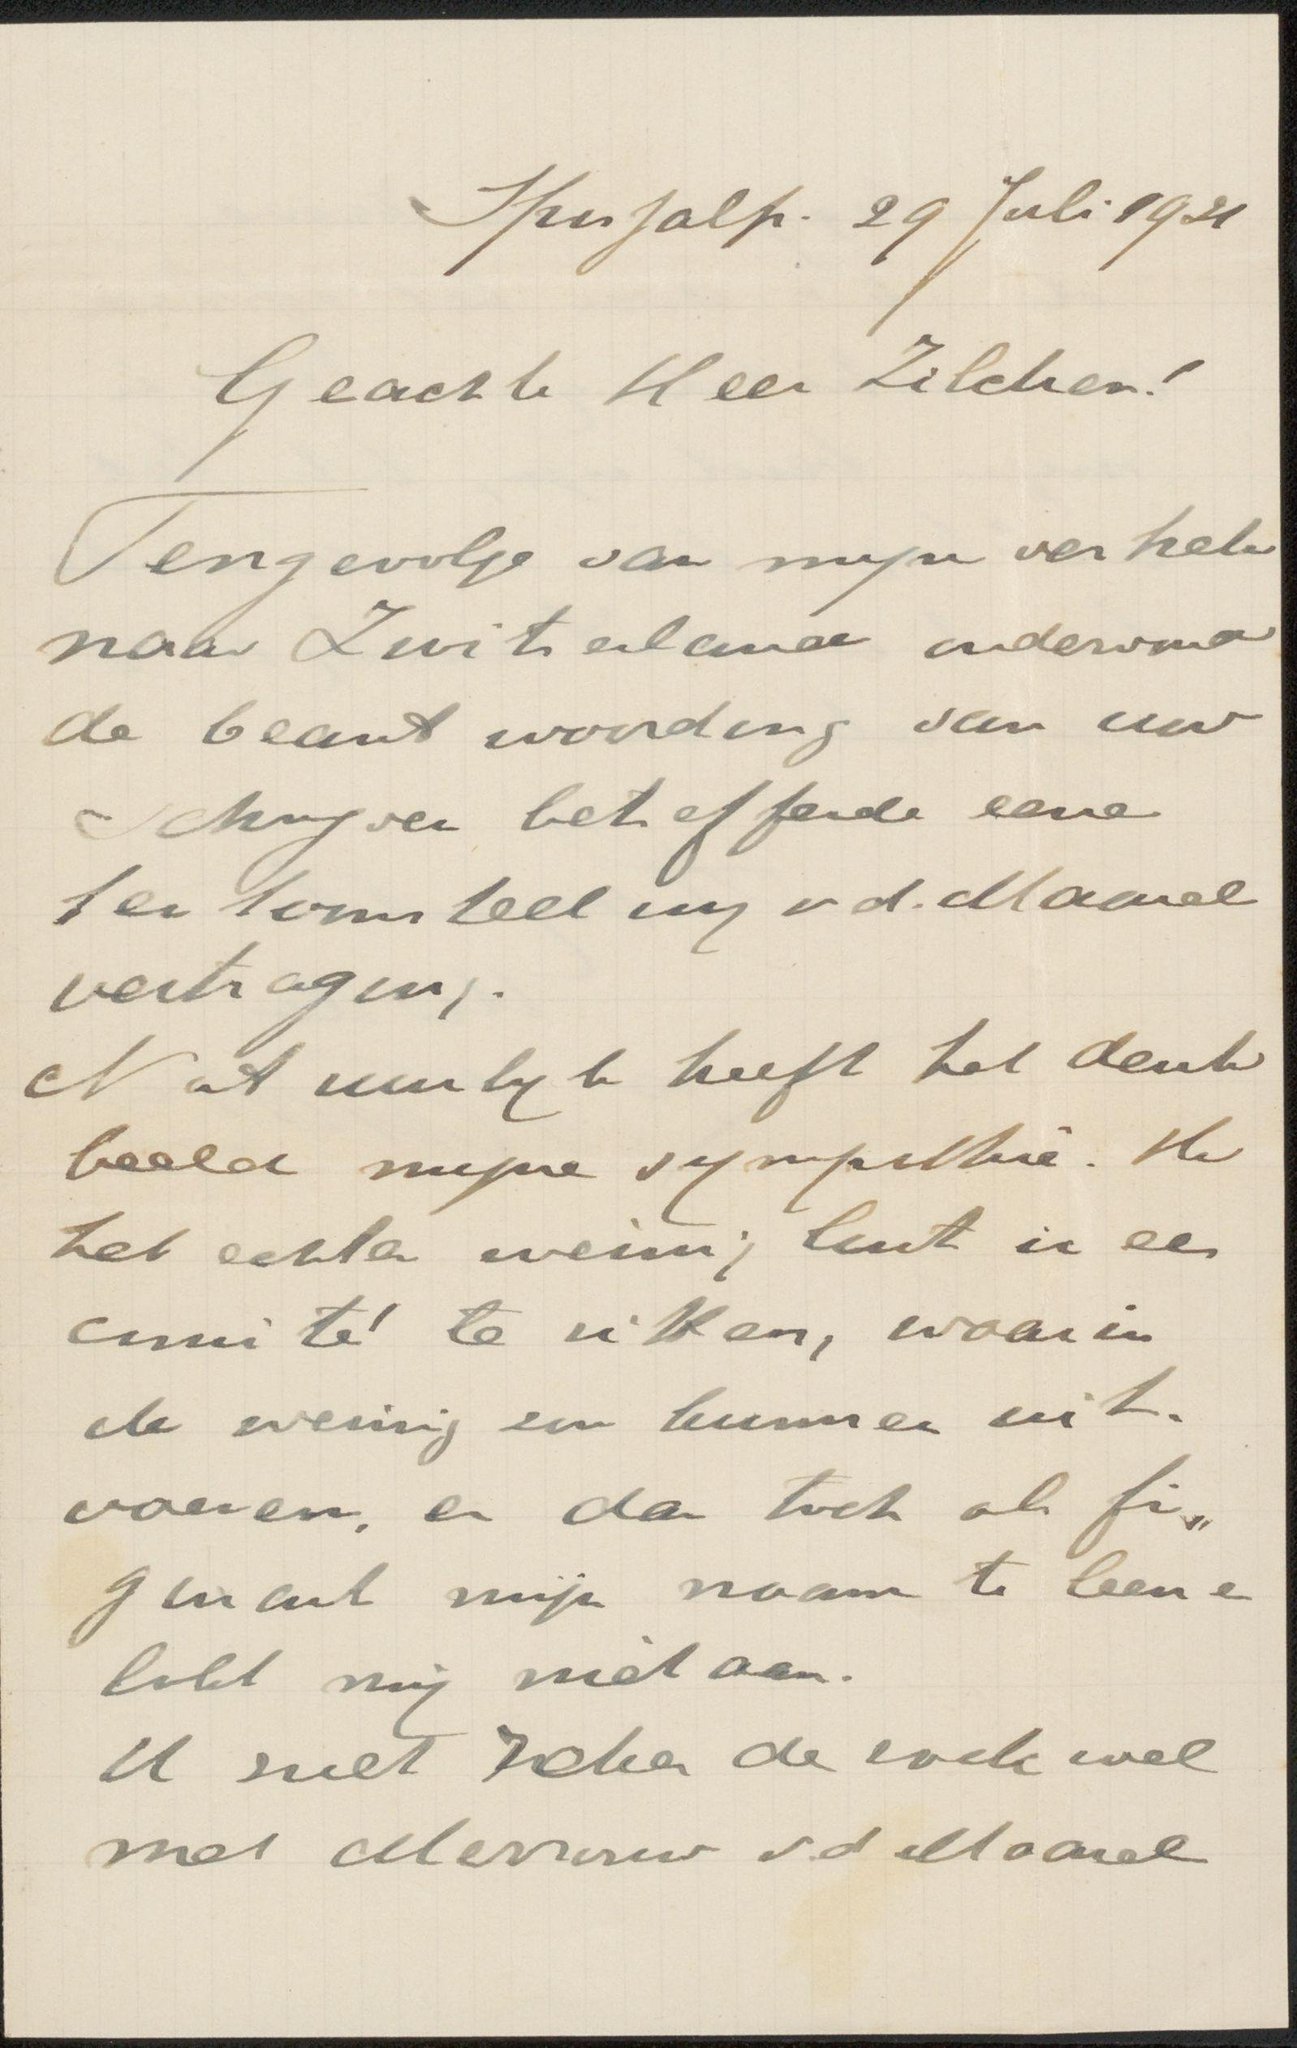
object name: letter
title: Brief aan Philip Zilcken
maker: l. verschoor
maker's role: schrijver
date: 1921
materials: ink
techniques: pen, writing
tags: the hague, painter, draughtsman, philip zilcken, the graphic arts, switzerland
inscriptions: collector's mark: ‘RPK’